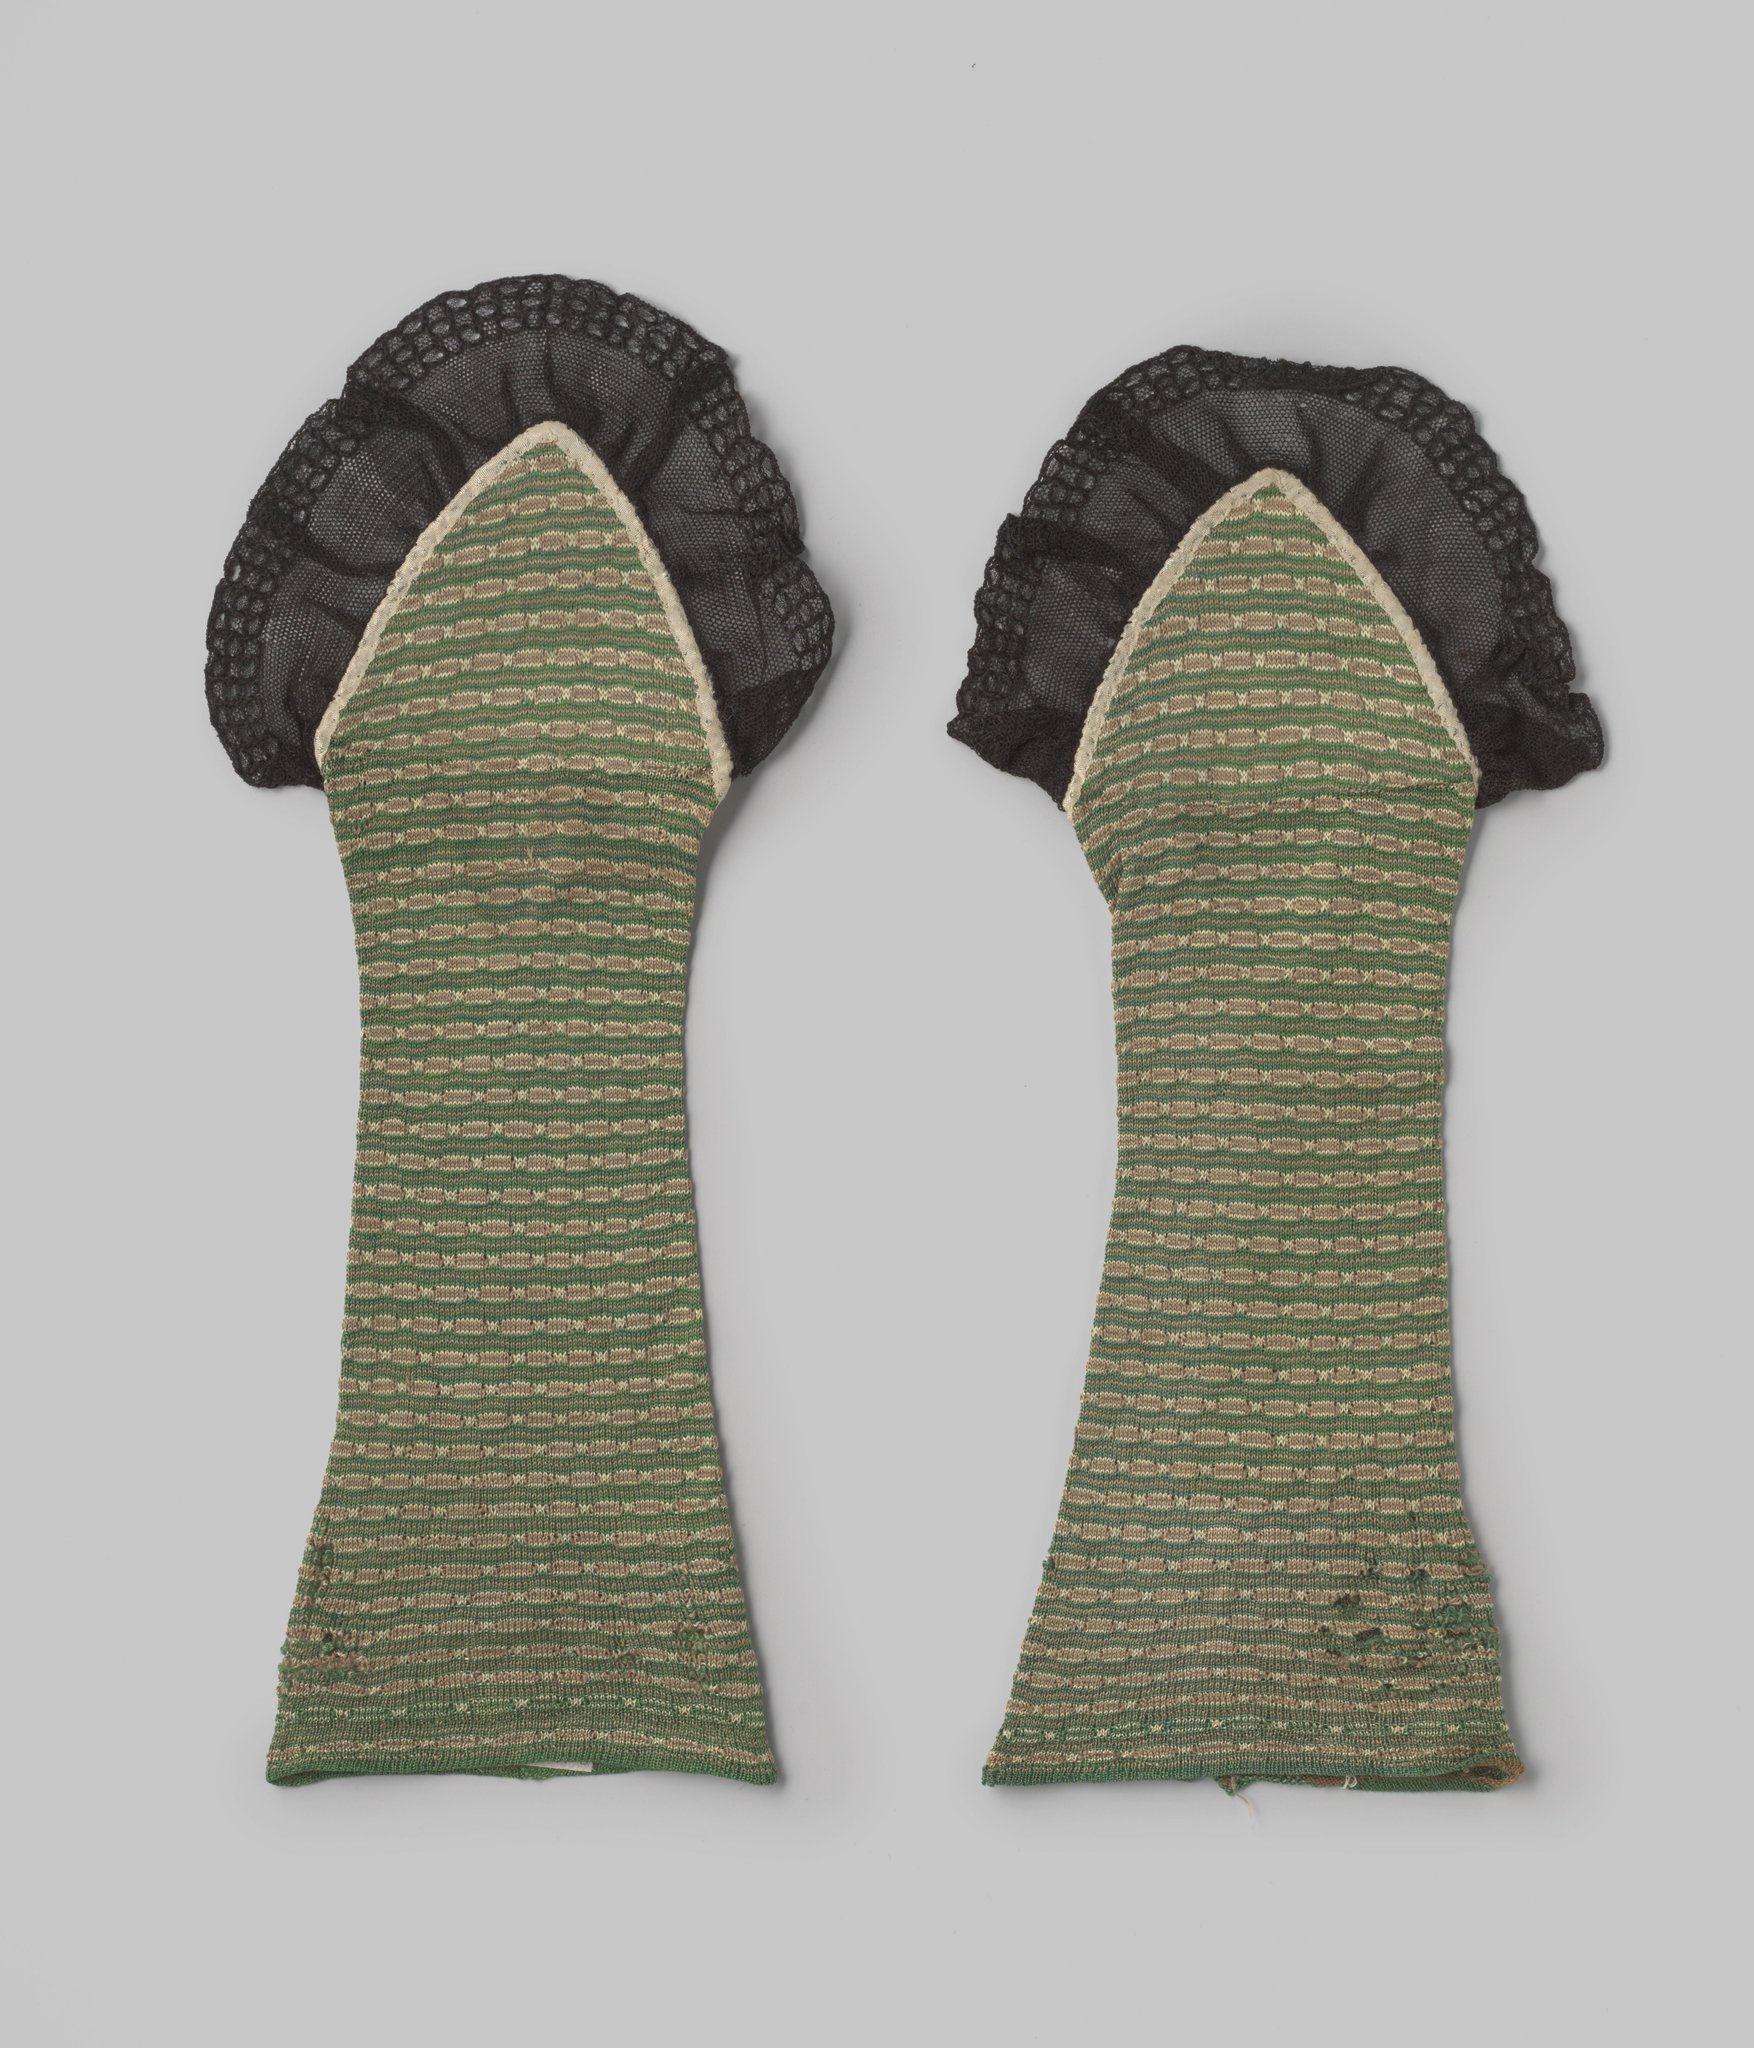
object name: mitt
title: Mitaine van zijde groen, beige en witgestreept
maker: Anonymous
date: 1800-1820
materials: silk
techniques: knitting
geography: zaanstreek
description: Een paar zijden mitaines in de breedte afwisselend groen met grijs en grijs met wit gestreept. Aan de onderzijde van zwarte kant voorzien.